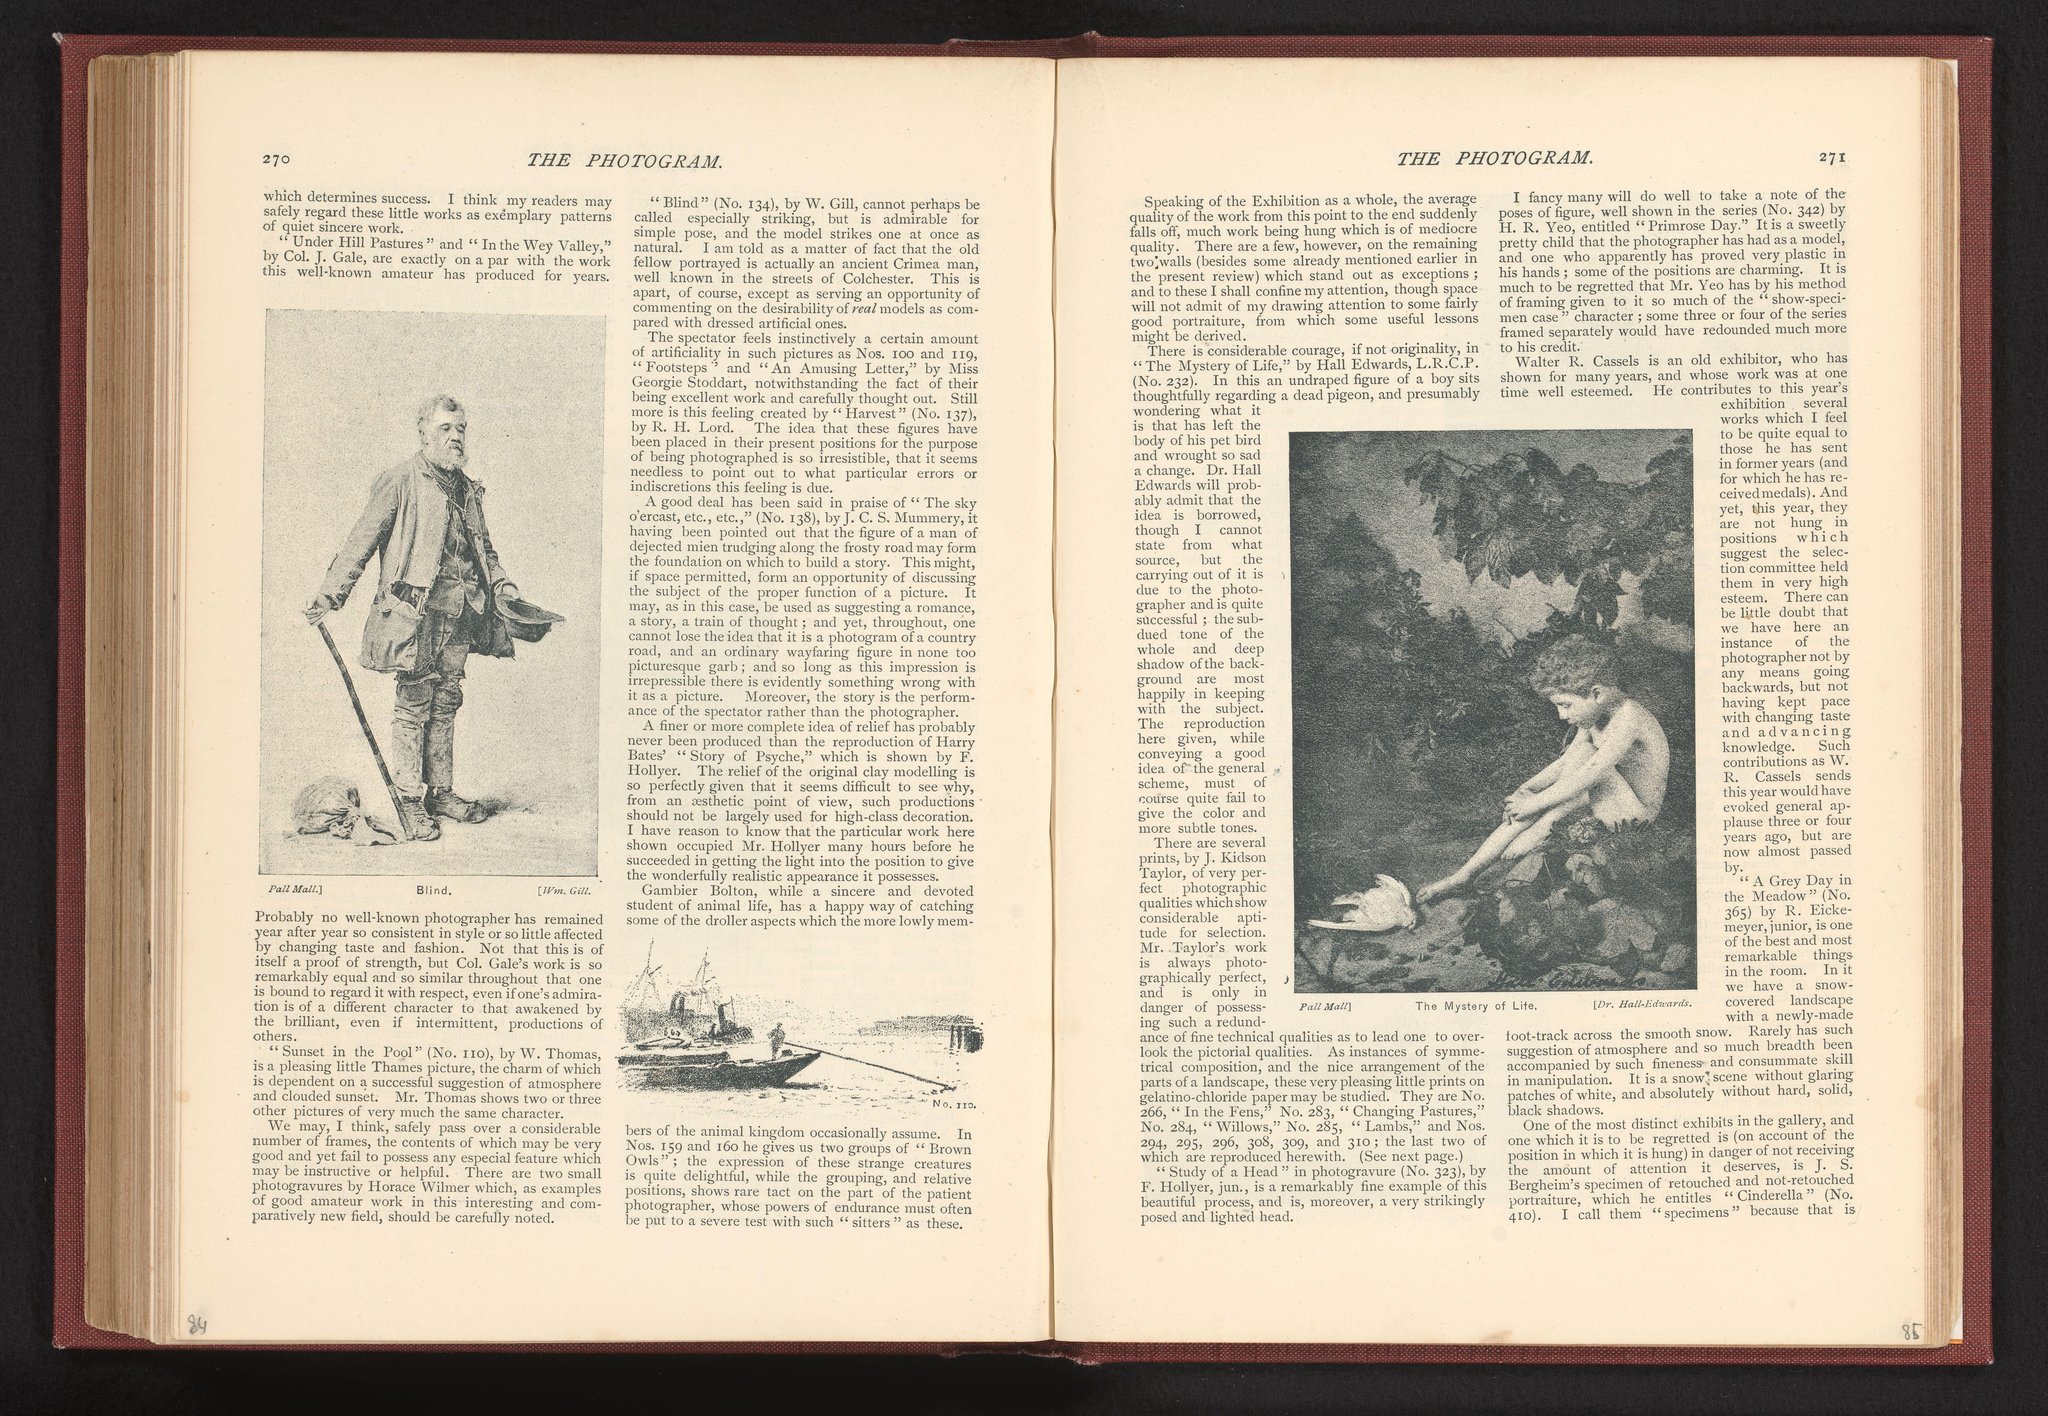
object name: page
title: The mystery of life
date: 1889-1894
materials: paper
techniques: autotype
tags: the (nude) human figure; 'corpo humano' (ripa), boy (child between toddler and youth), doves, pigeons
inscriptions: inscription: ‘Pall Mall’